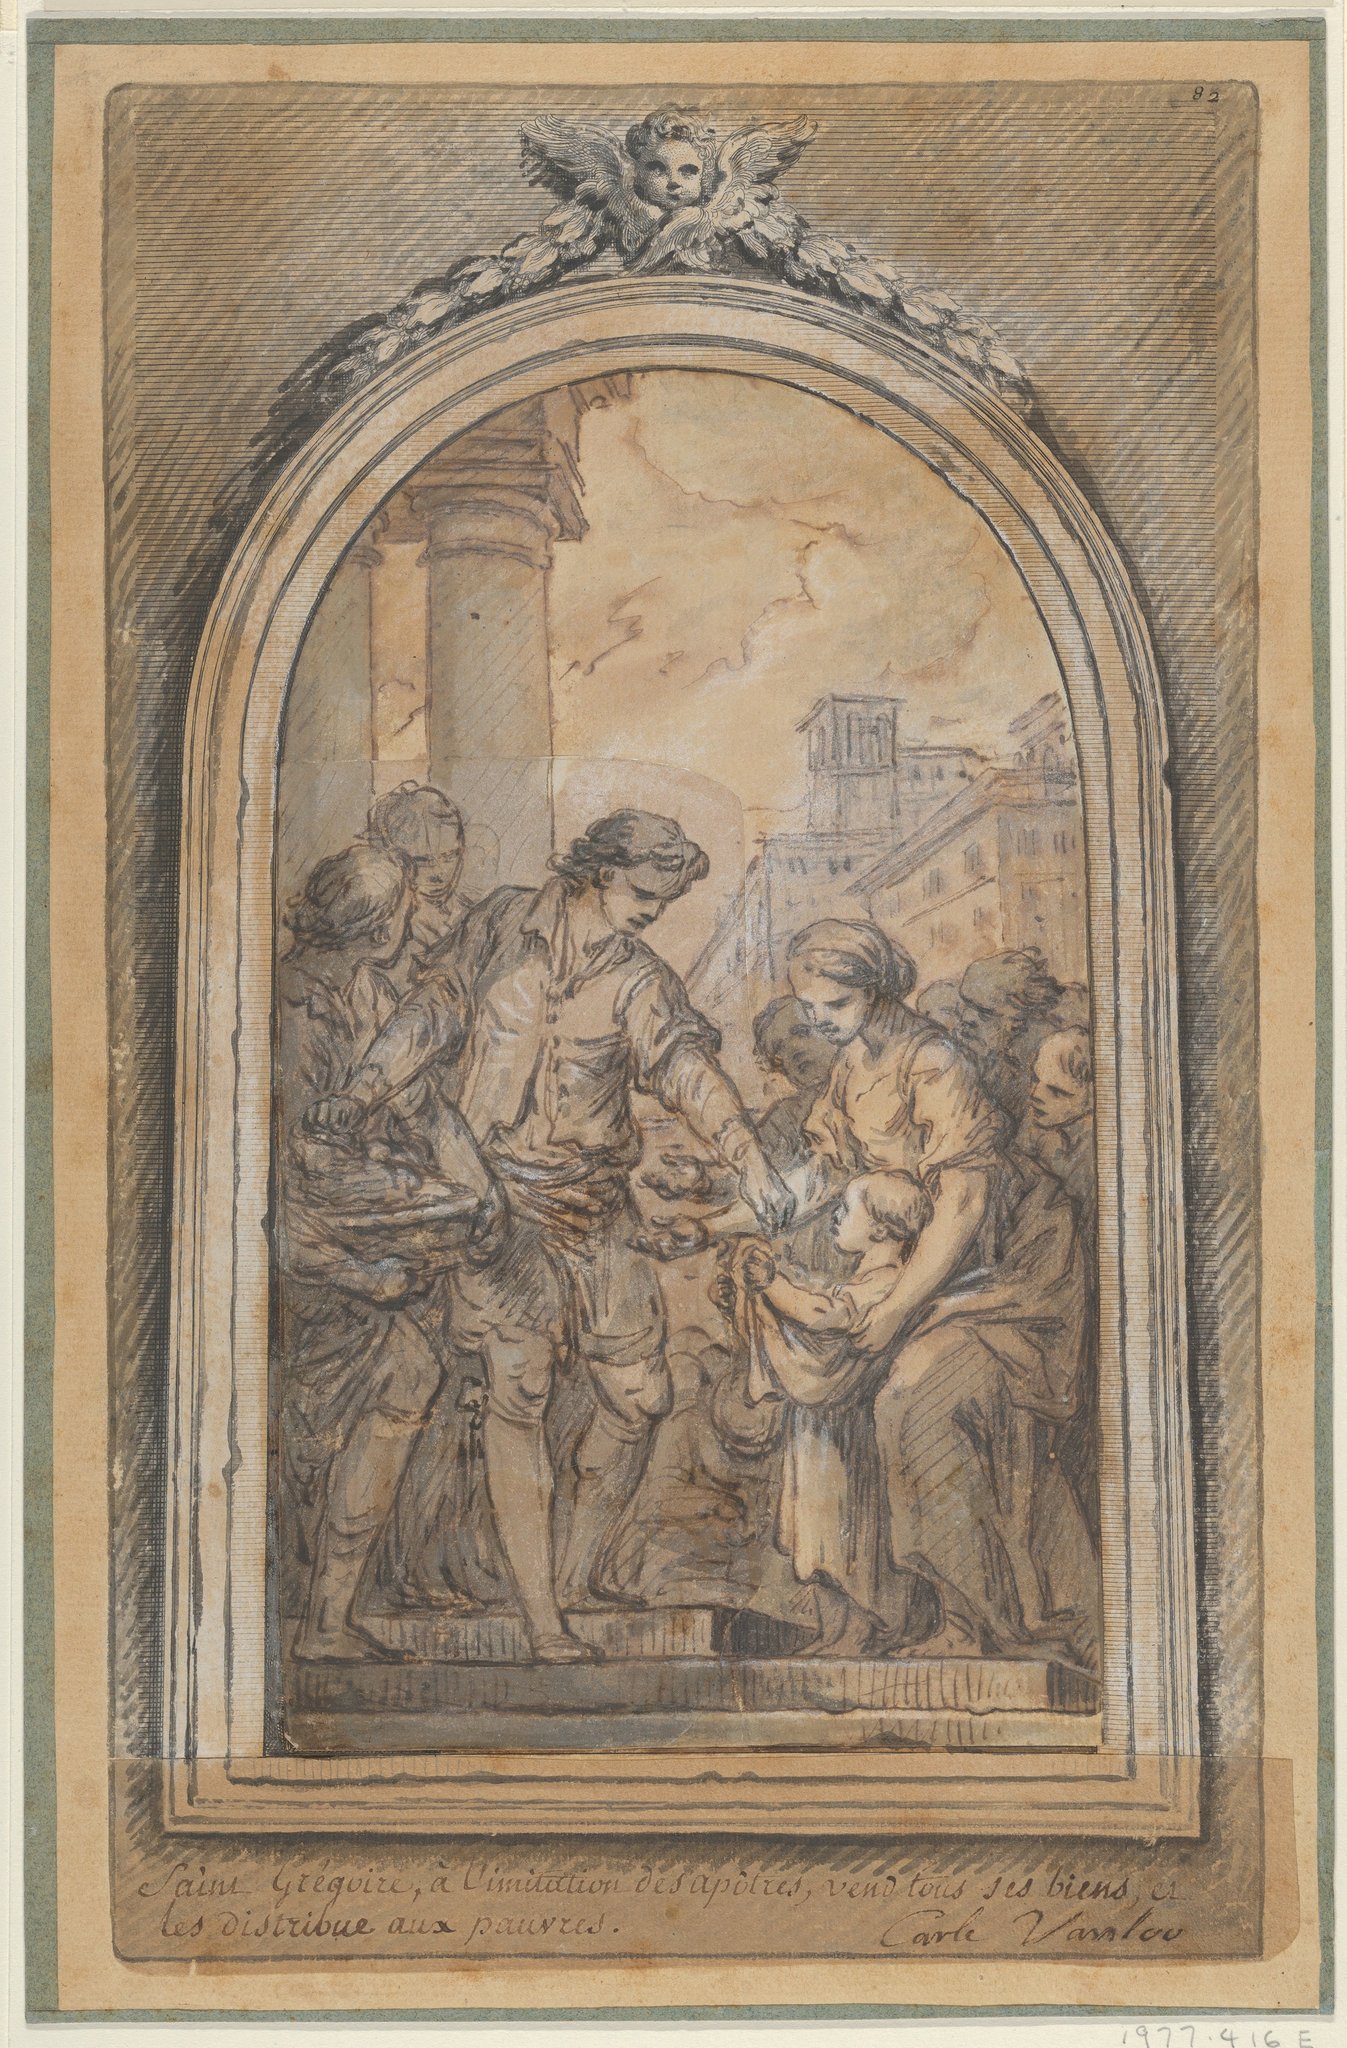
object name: drawing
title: St. Gregory Distributing His Worldly Goods to the Poor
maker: carle (charles andré) vanloo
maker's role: artist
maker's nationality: french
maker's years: 1705-1765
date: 1701-1800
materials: ink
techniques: brush, pen, wash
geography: france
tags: men,saints